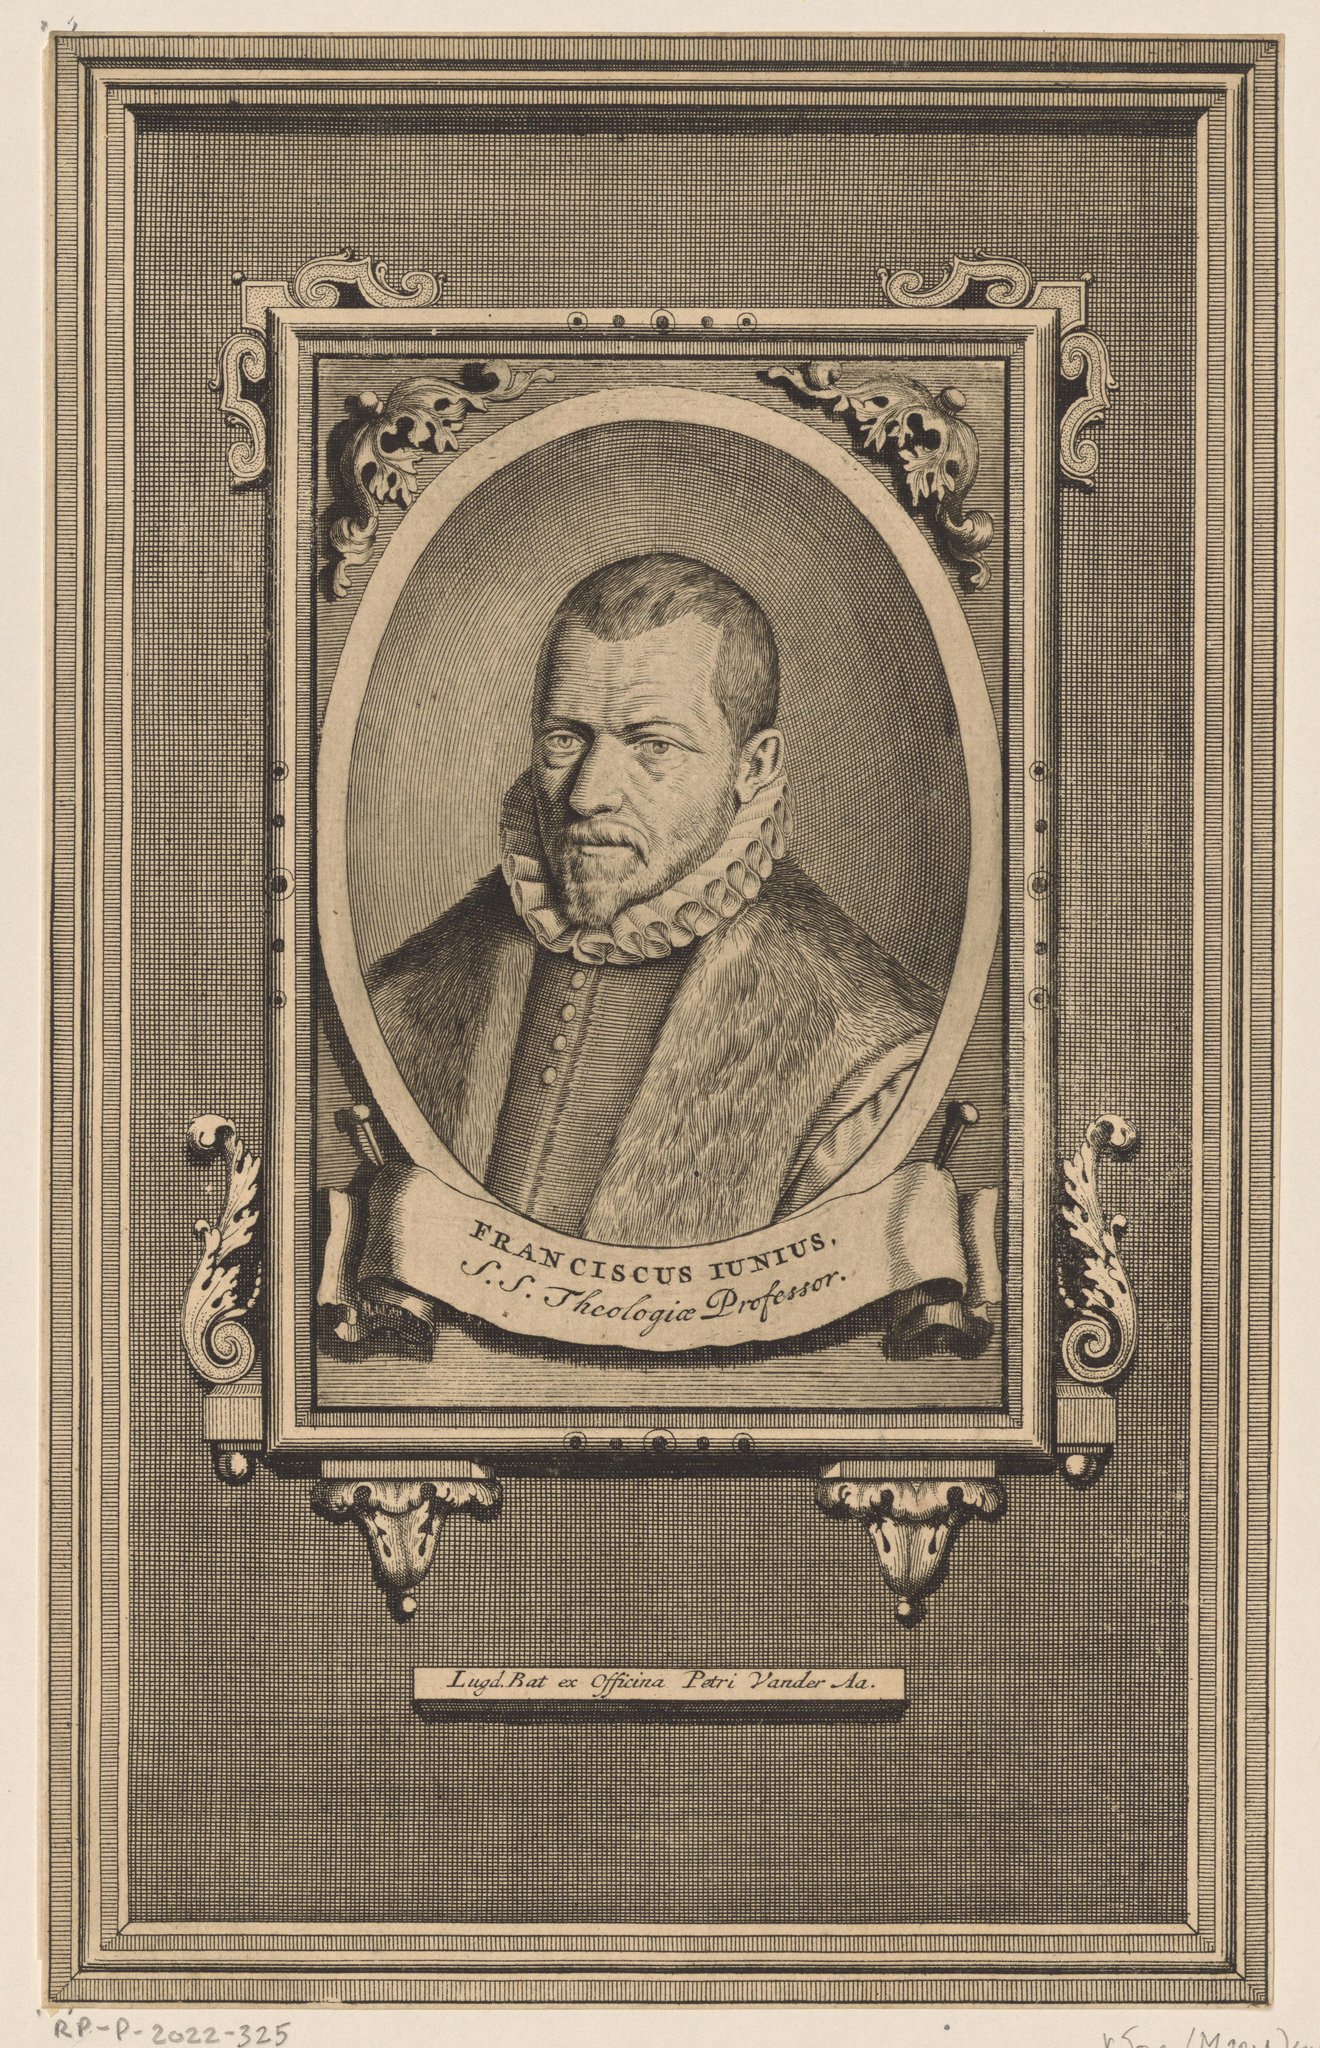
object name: print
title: Portret van Franciscus Junius I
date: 1720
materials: paper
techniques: engraving, etching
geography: leiden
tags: leiden, theologian, historical persons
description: Prent waarschijnlijk uit: Fundatoris, curatorum et professorum celeberrimorum, aliorumque illustrium virorum (...). Leiden: Pieter van der Aa, [1720].